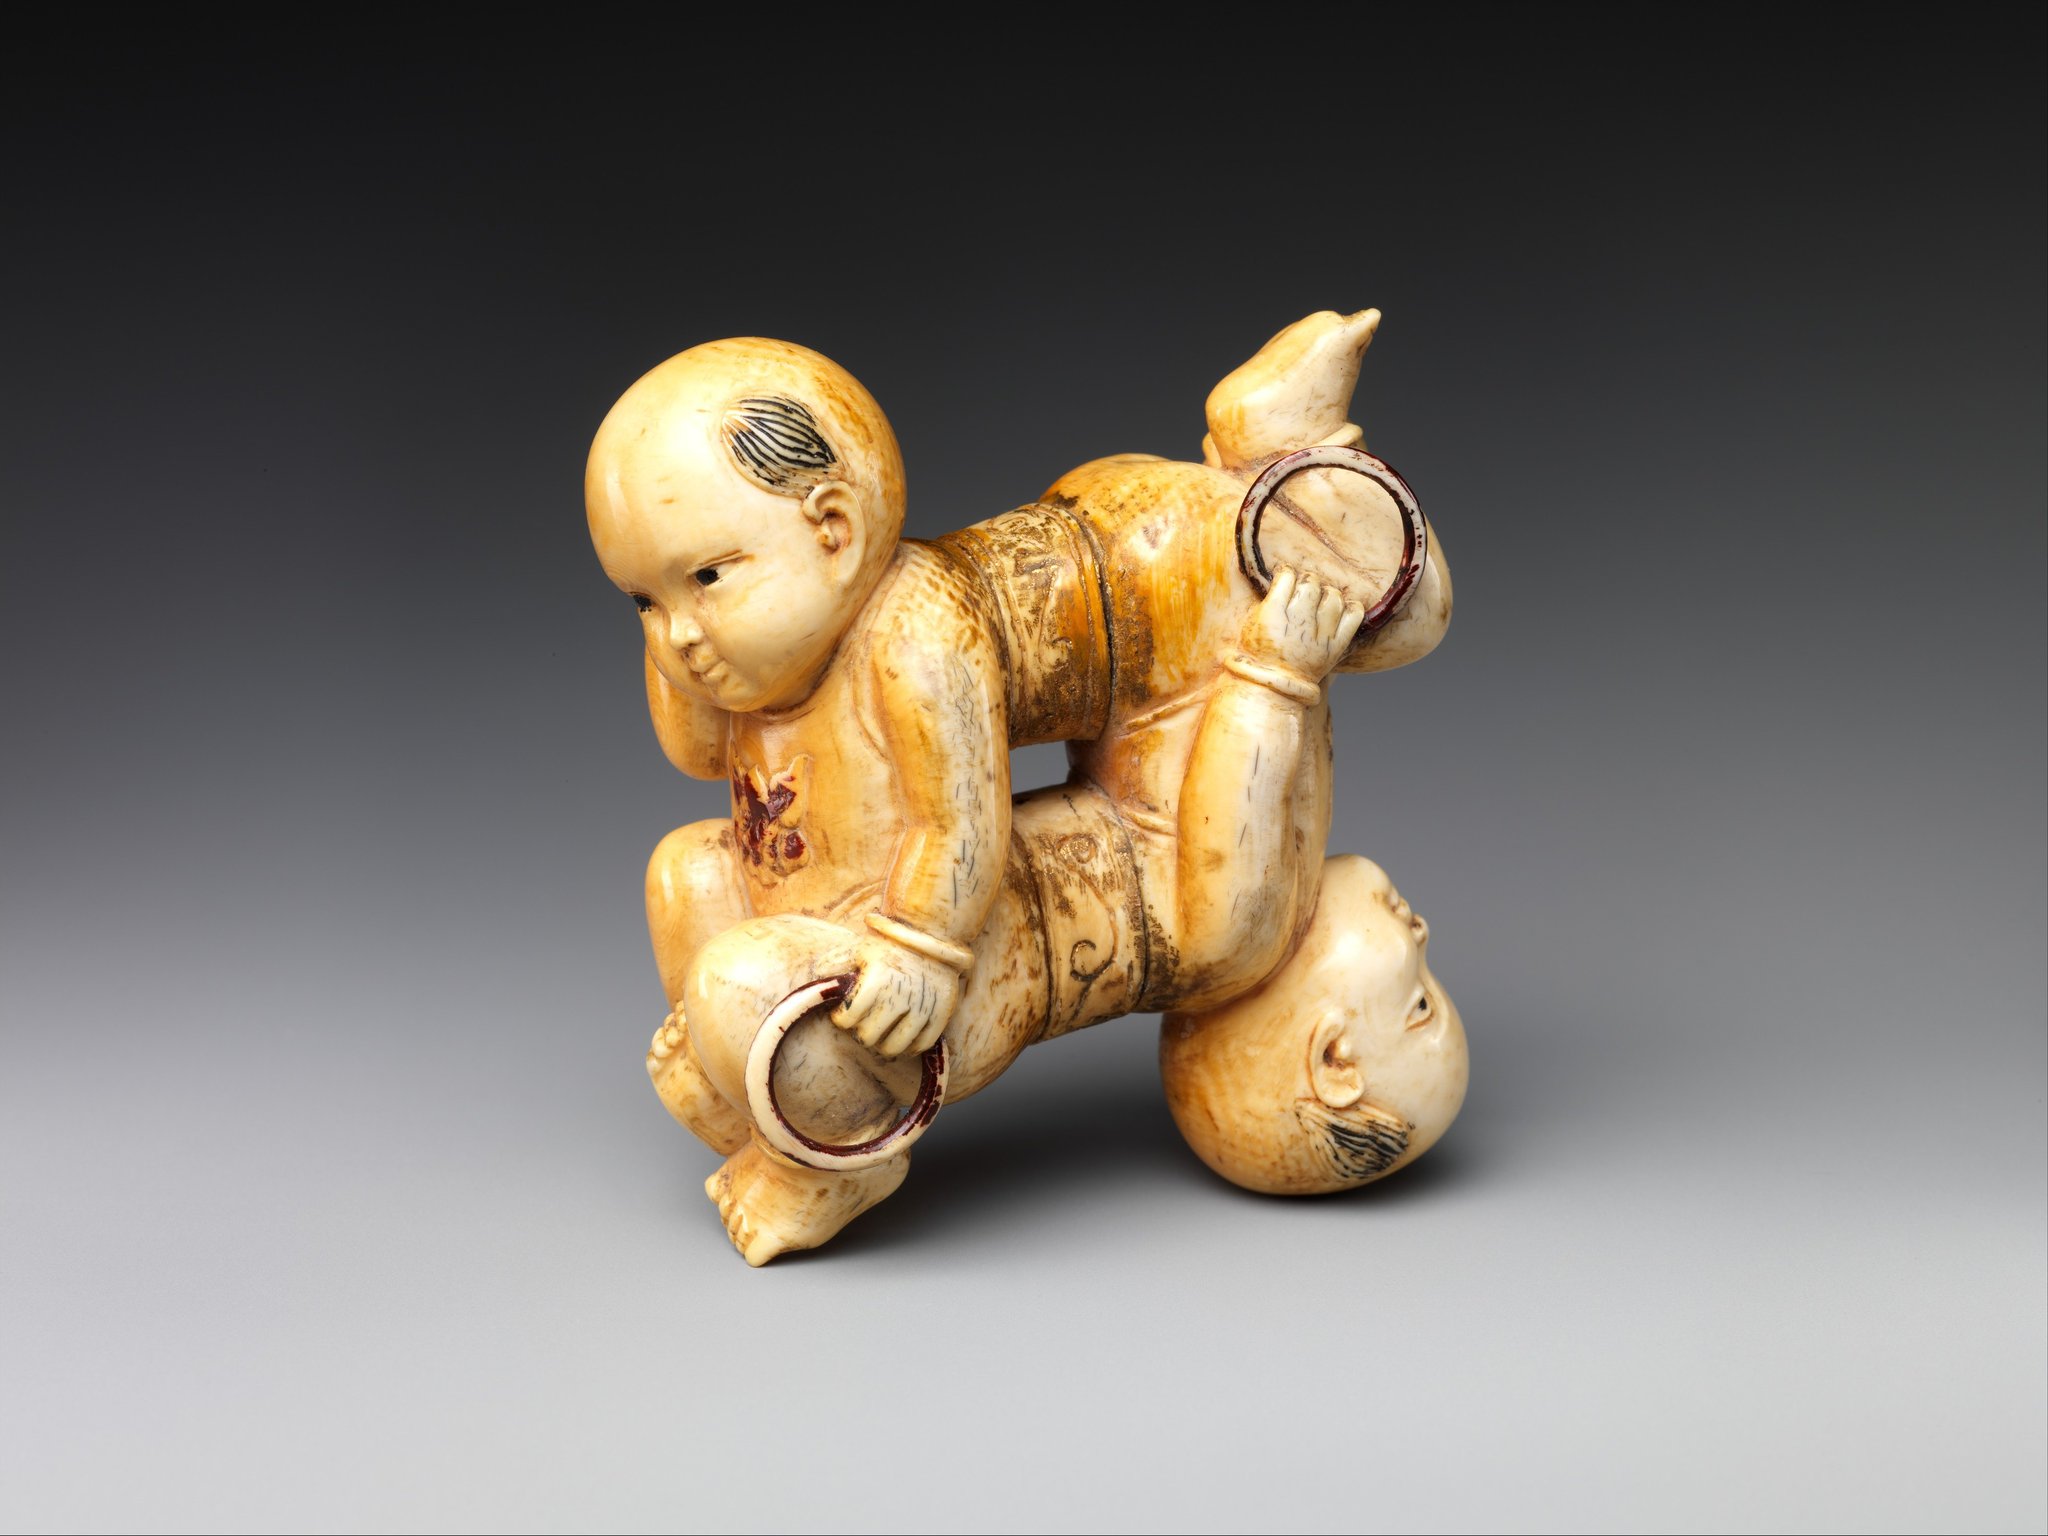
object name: figurine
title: Twin boys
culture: chinese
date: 1701-1800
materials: ivory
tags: boys